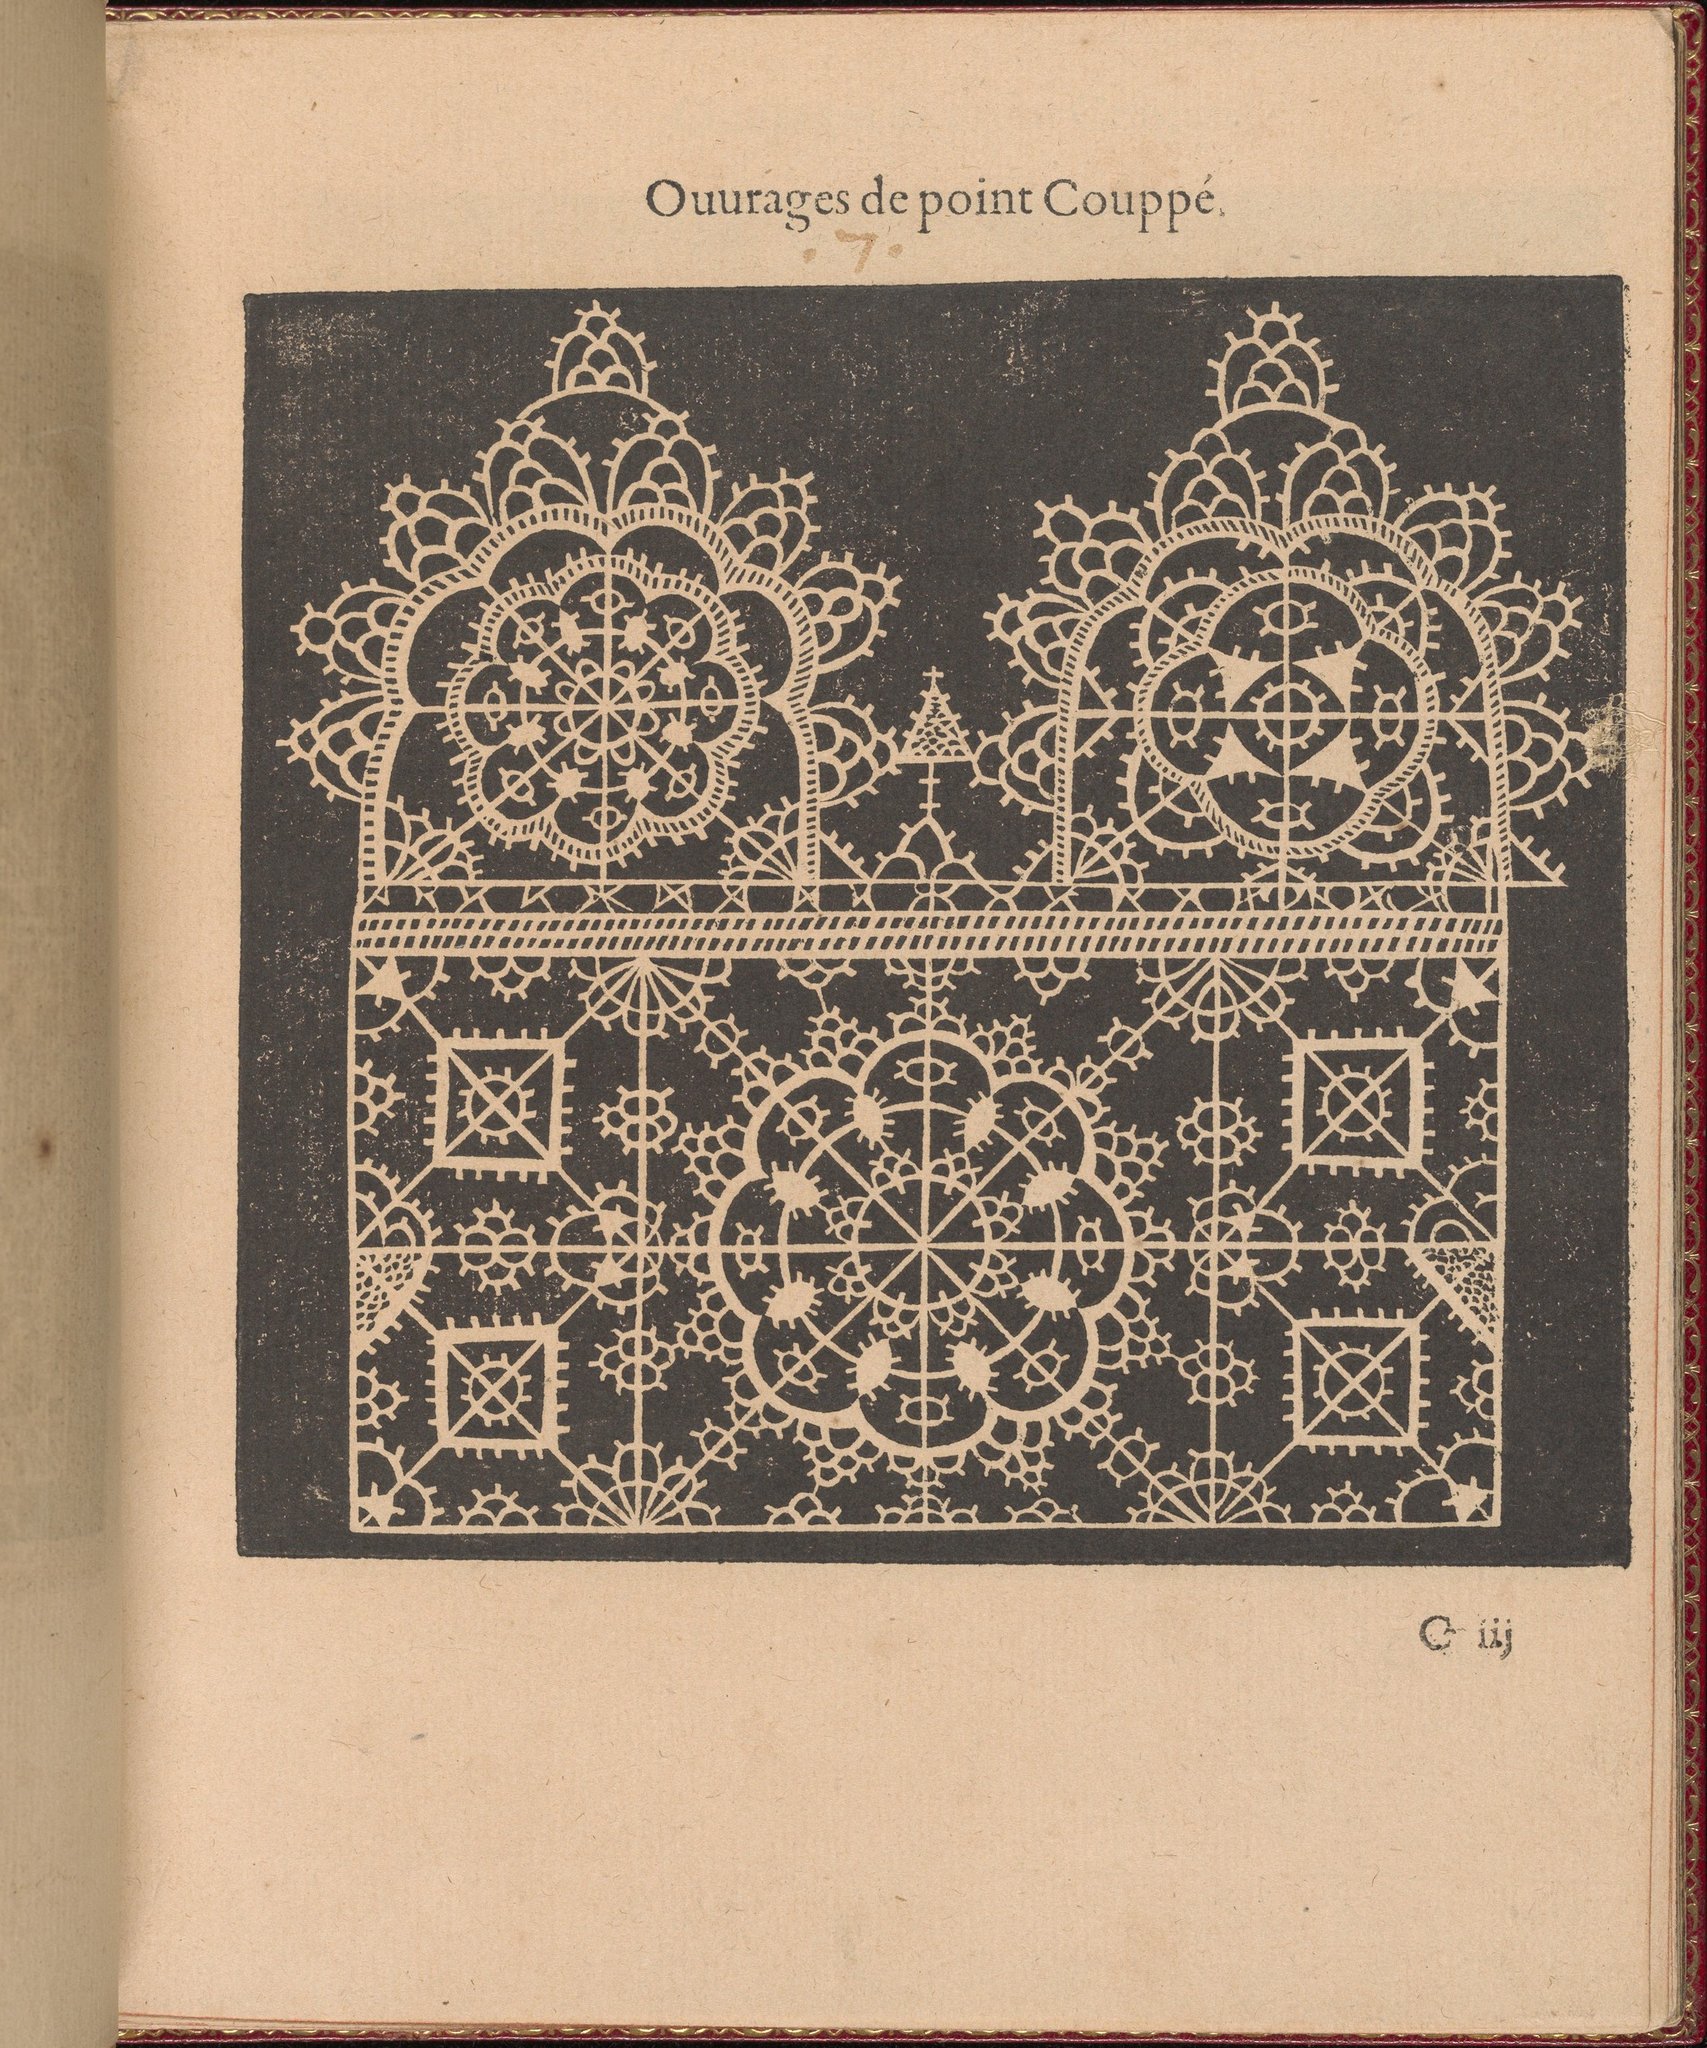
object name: book print ornament architecture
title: Les Singuliers et Nouveaux Portraicts... page 11 (recto)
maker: federico de vinciolo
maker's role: designer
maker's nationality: italian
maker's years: 1582-1599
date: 1588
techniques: woodcut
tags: ornament